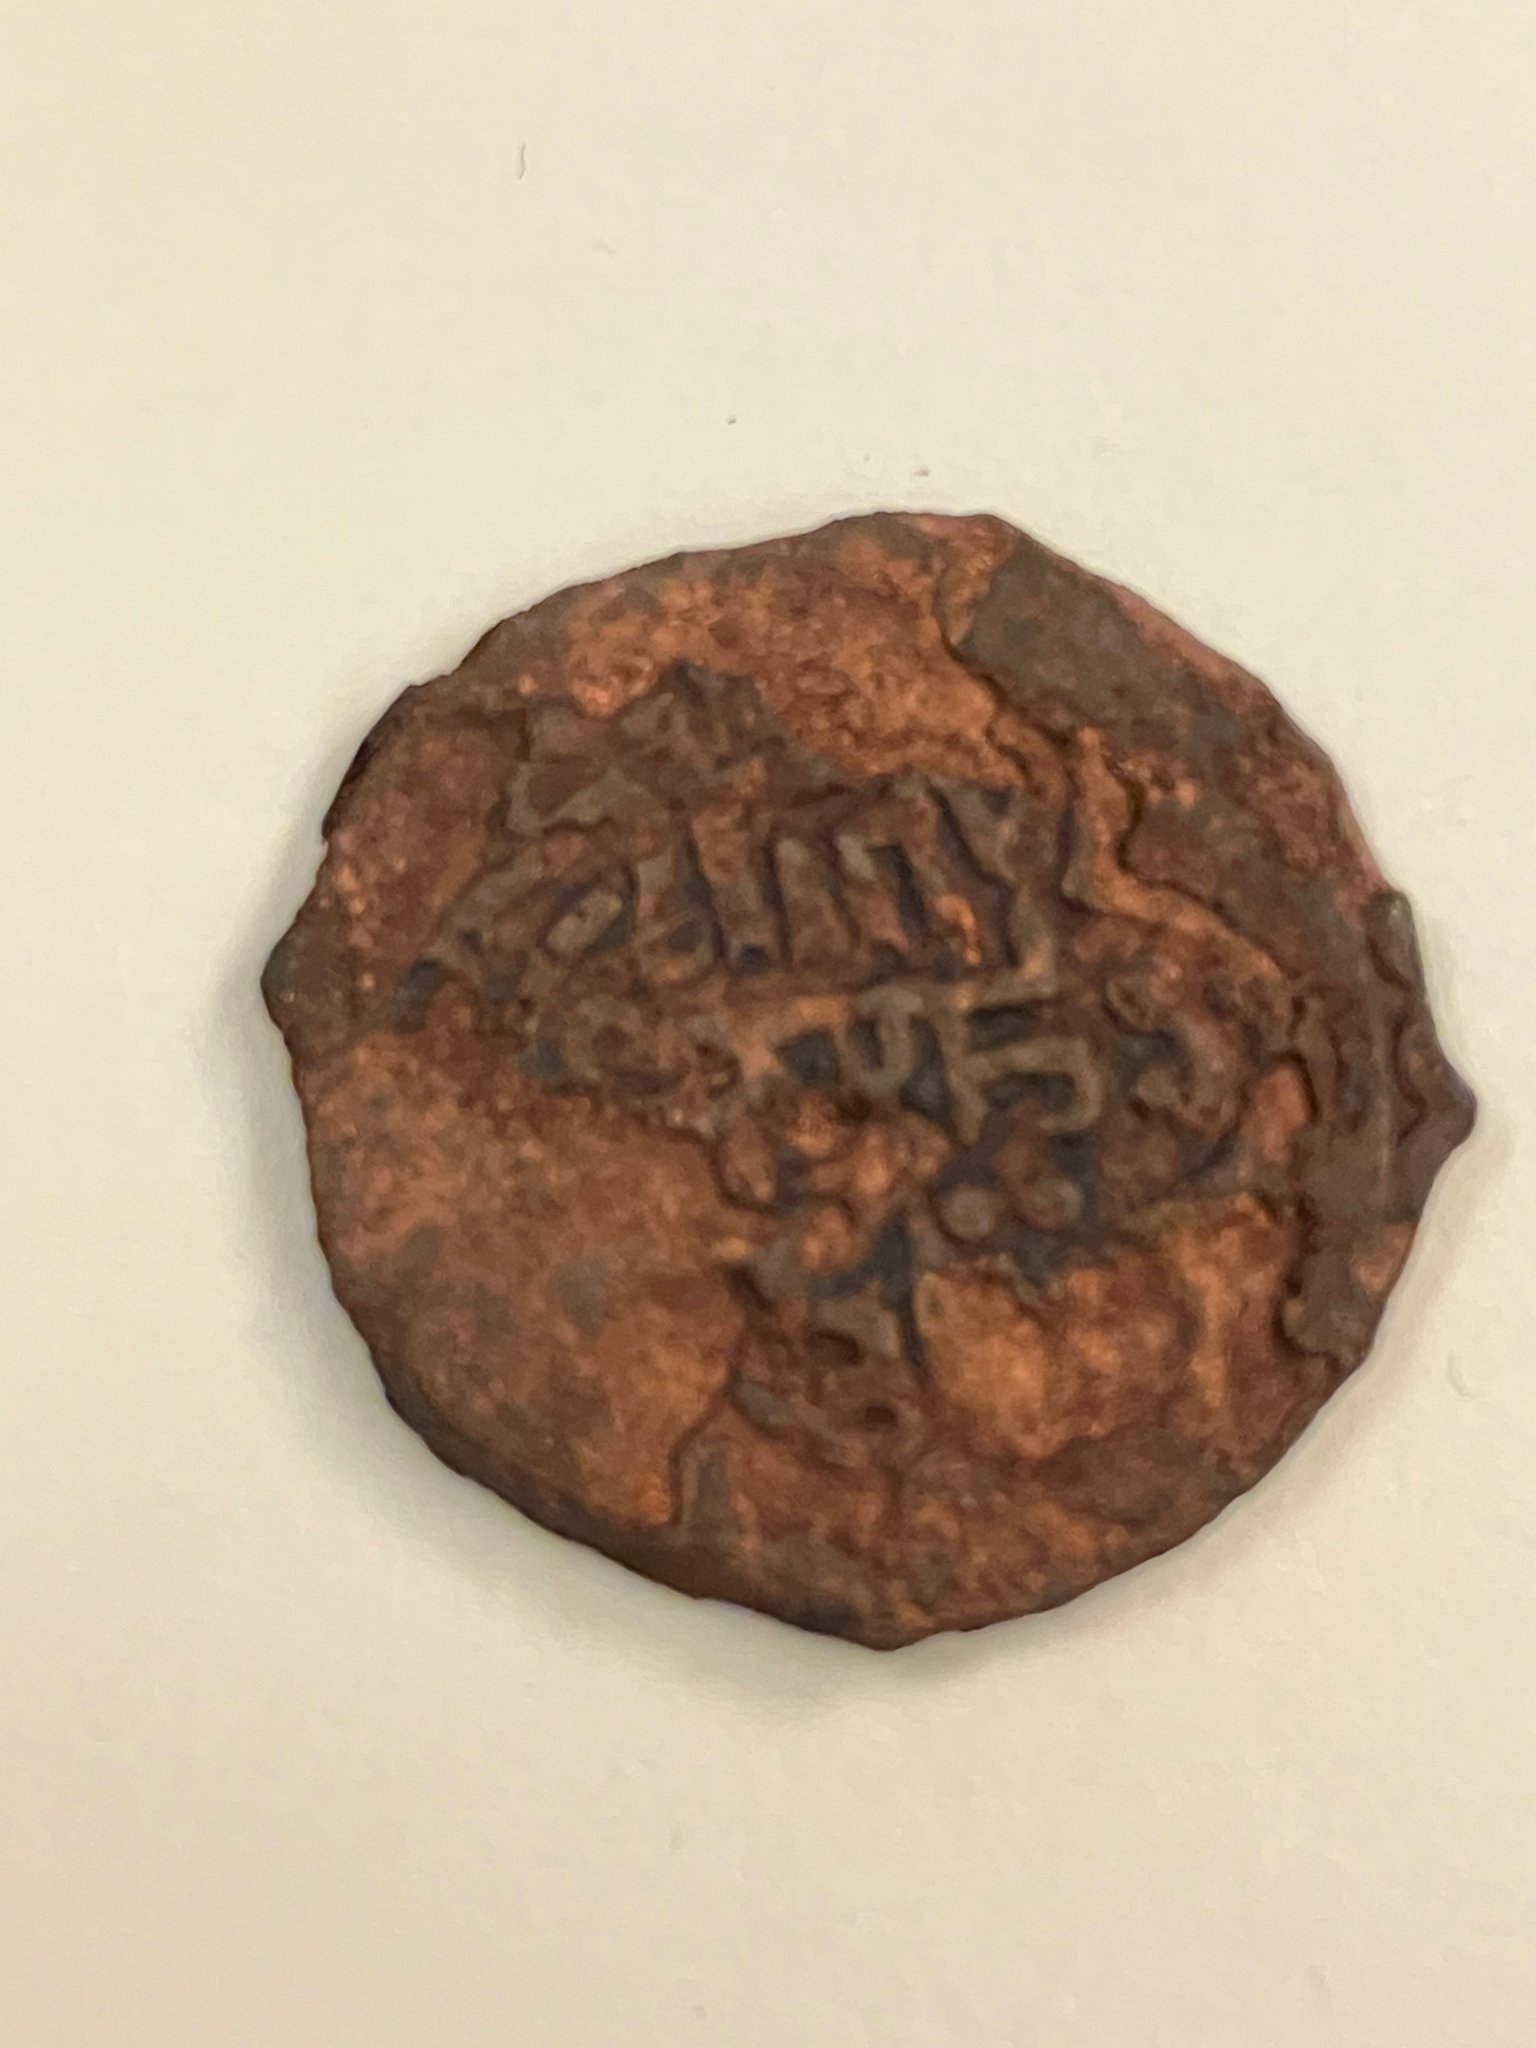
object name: coin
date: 401-1400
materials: copper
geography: iran